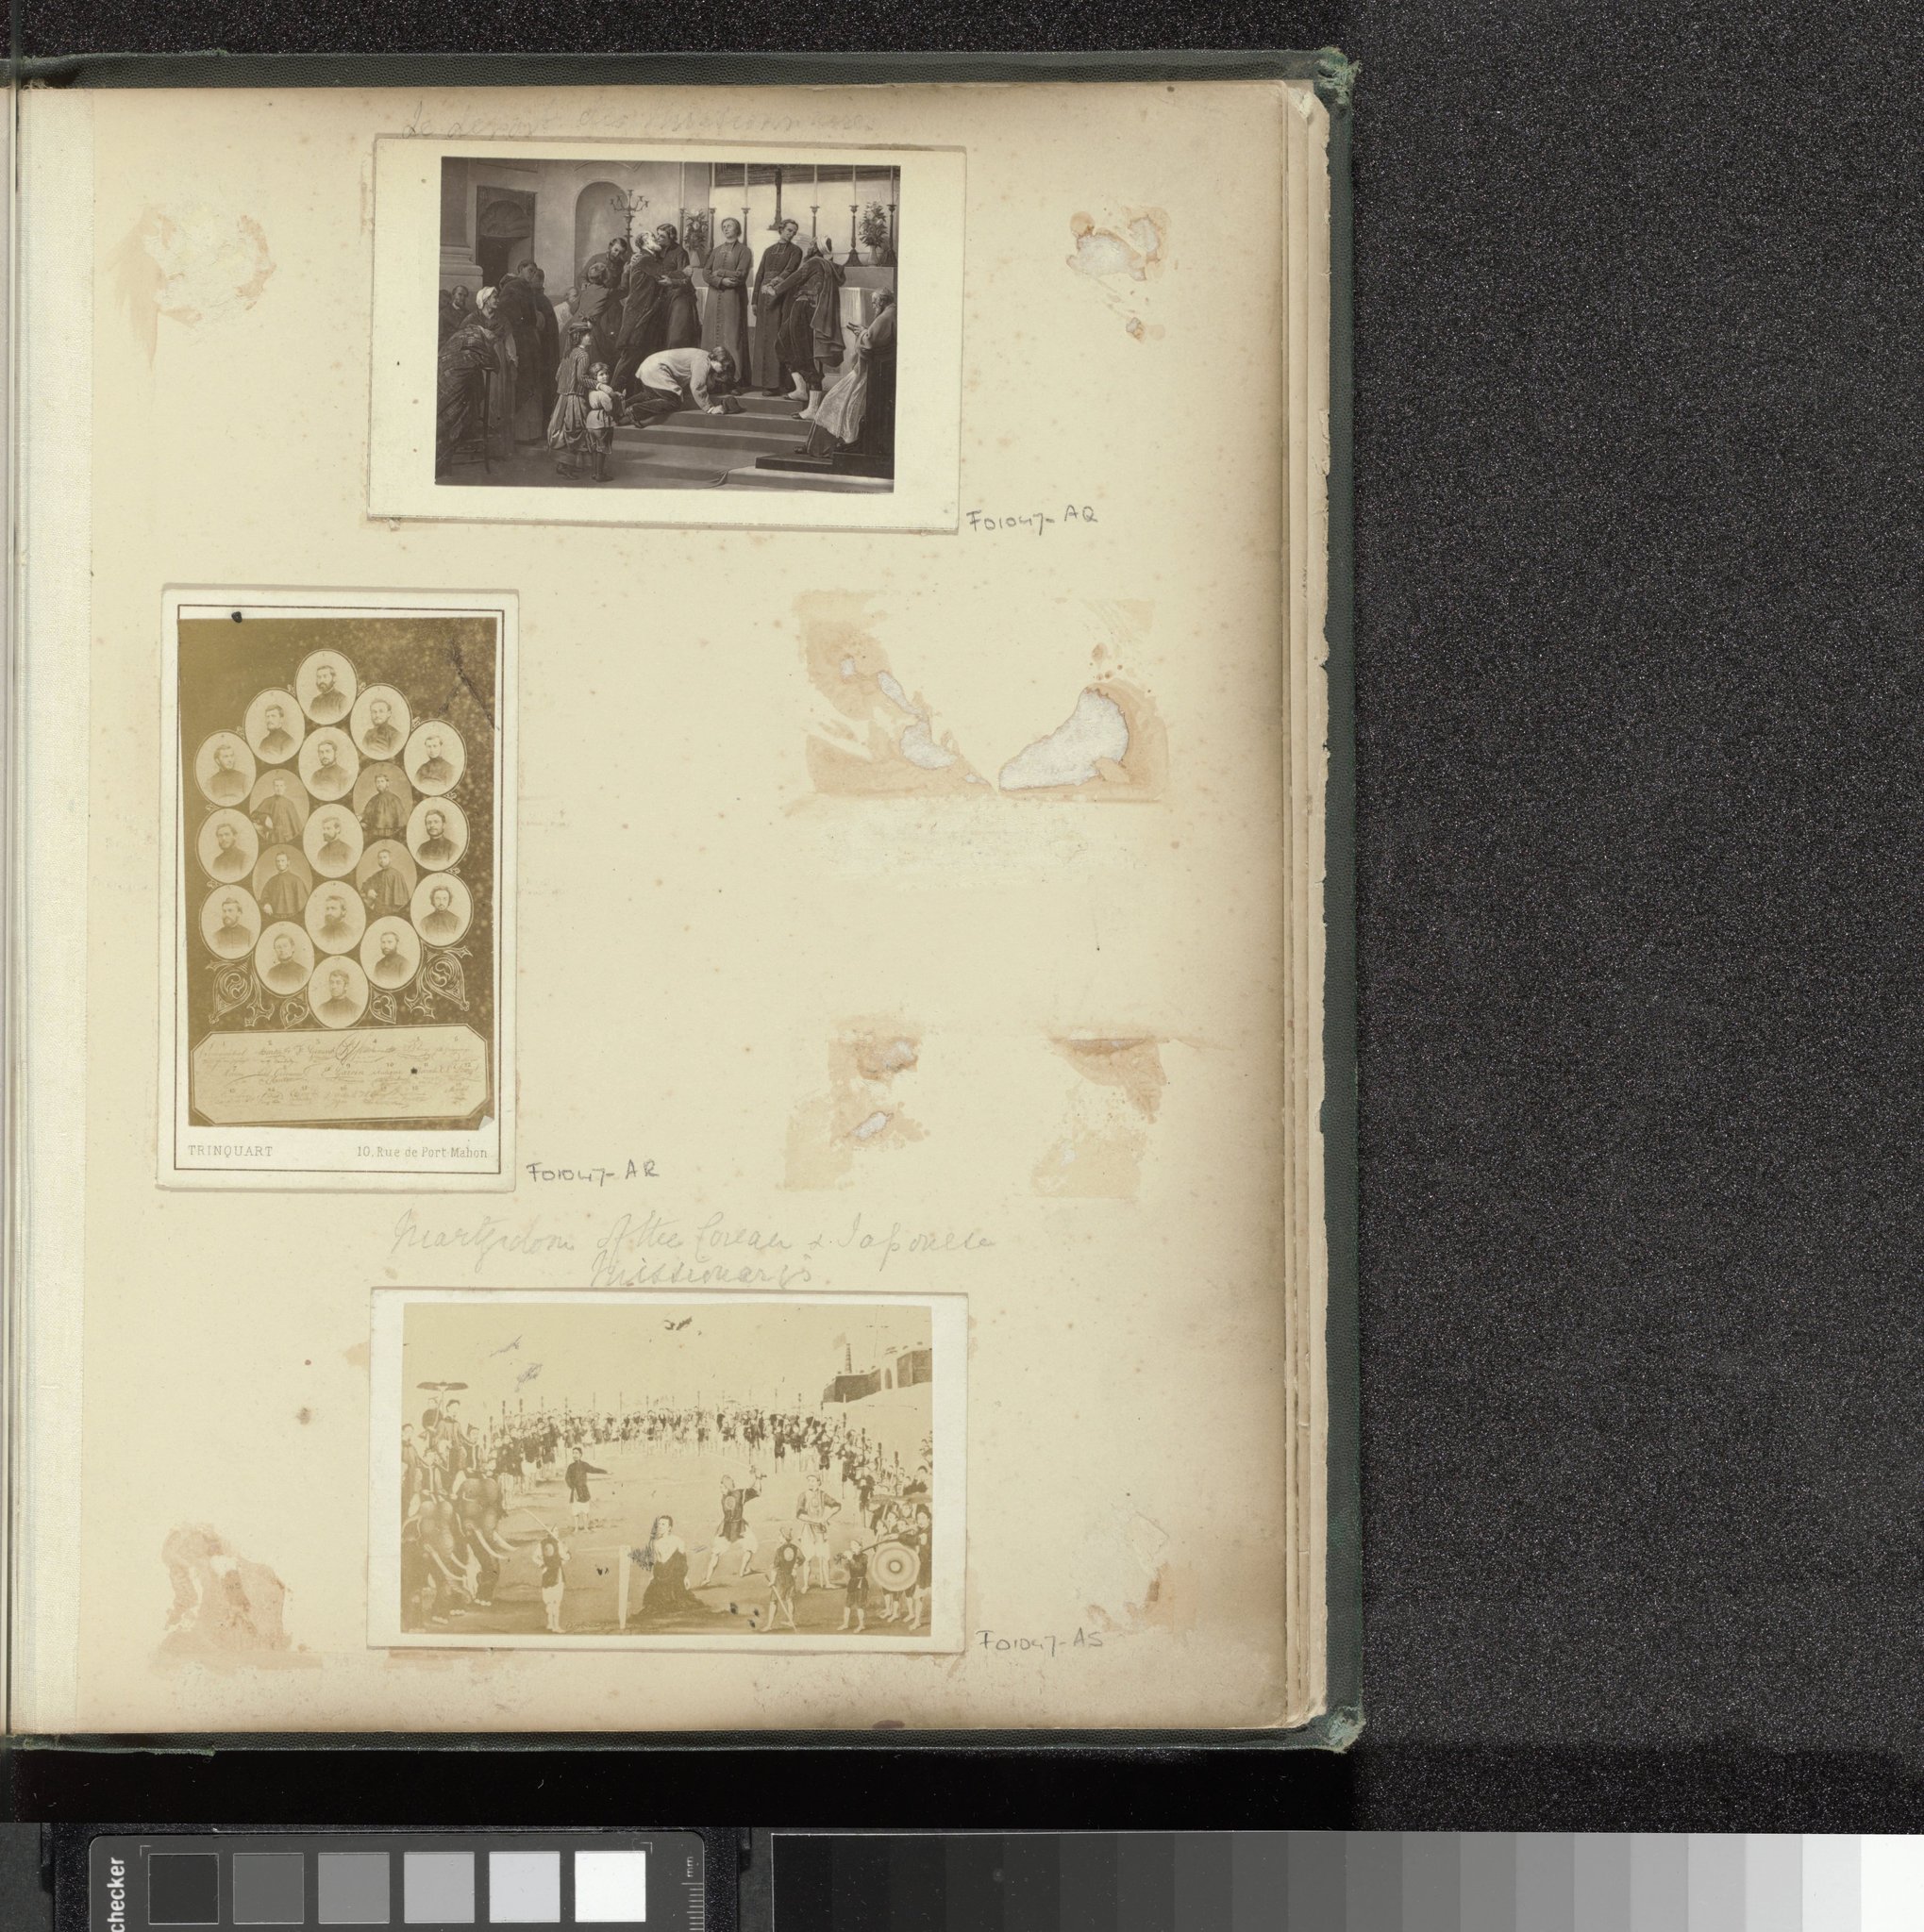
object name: photomontage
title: Overzicht van medaillons van geestelijken en handtekeningen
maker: antoine rené trinquart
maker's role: fotograaf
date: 1871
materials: cardboard, paper, photographic support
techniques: albumen print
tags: priest (roman catholic)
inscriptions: address: ‘10, Rue de Port Mahon’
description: Onderdeel van Herdenkingsalbum van rooms-katholieke geestelijken gevallen tijdens de Commune van Parijs.